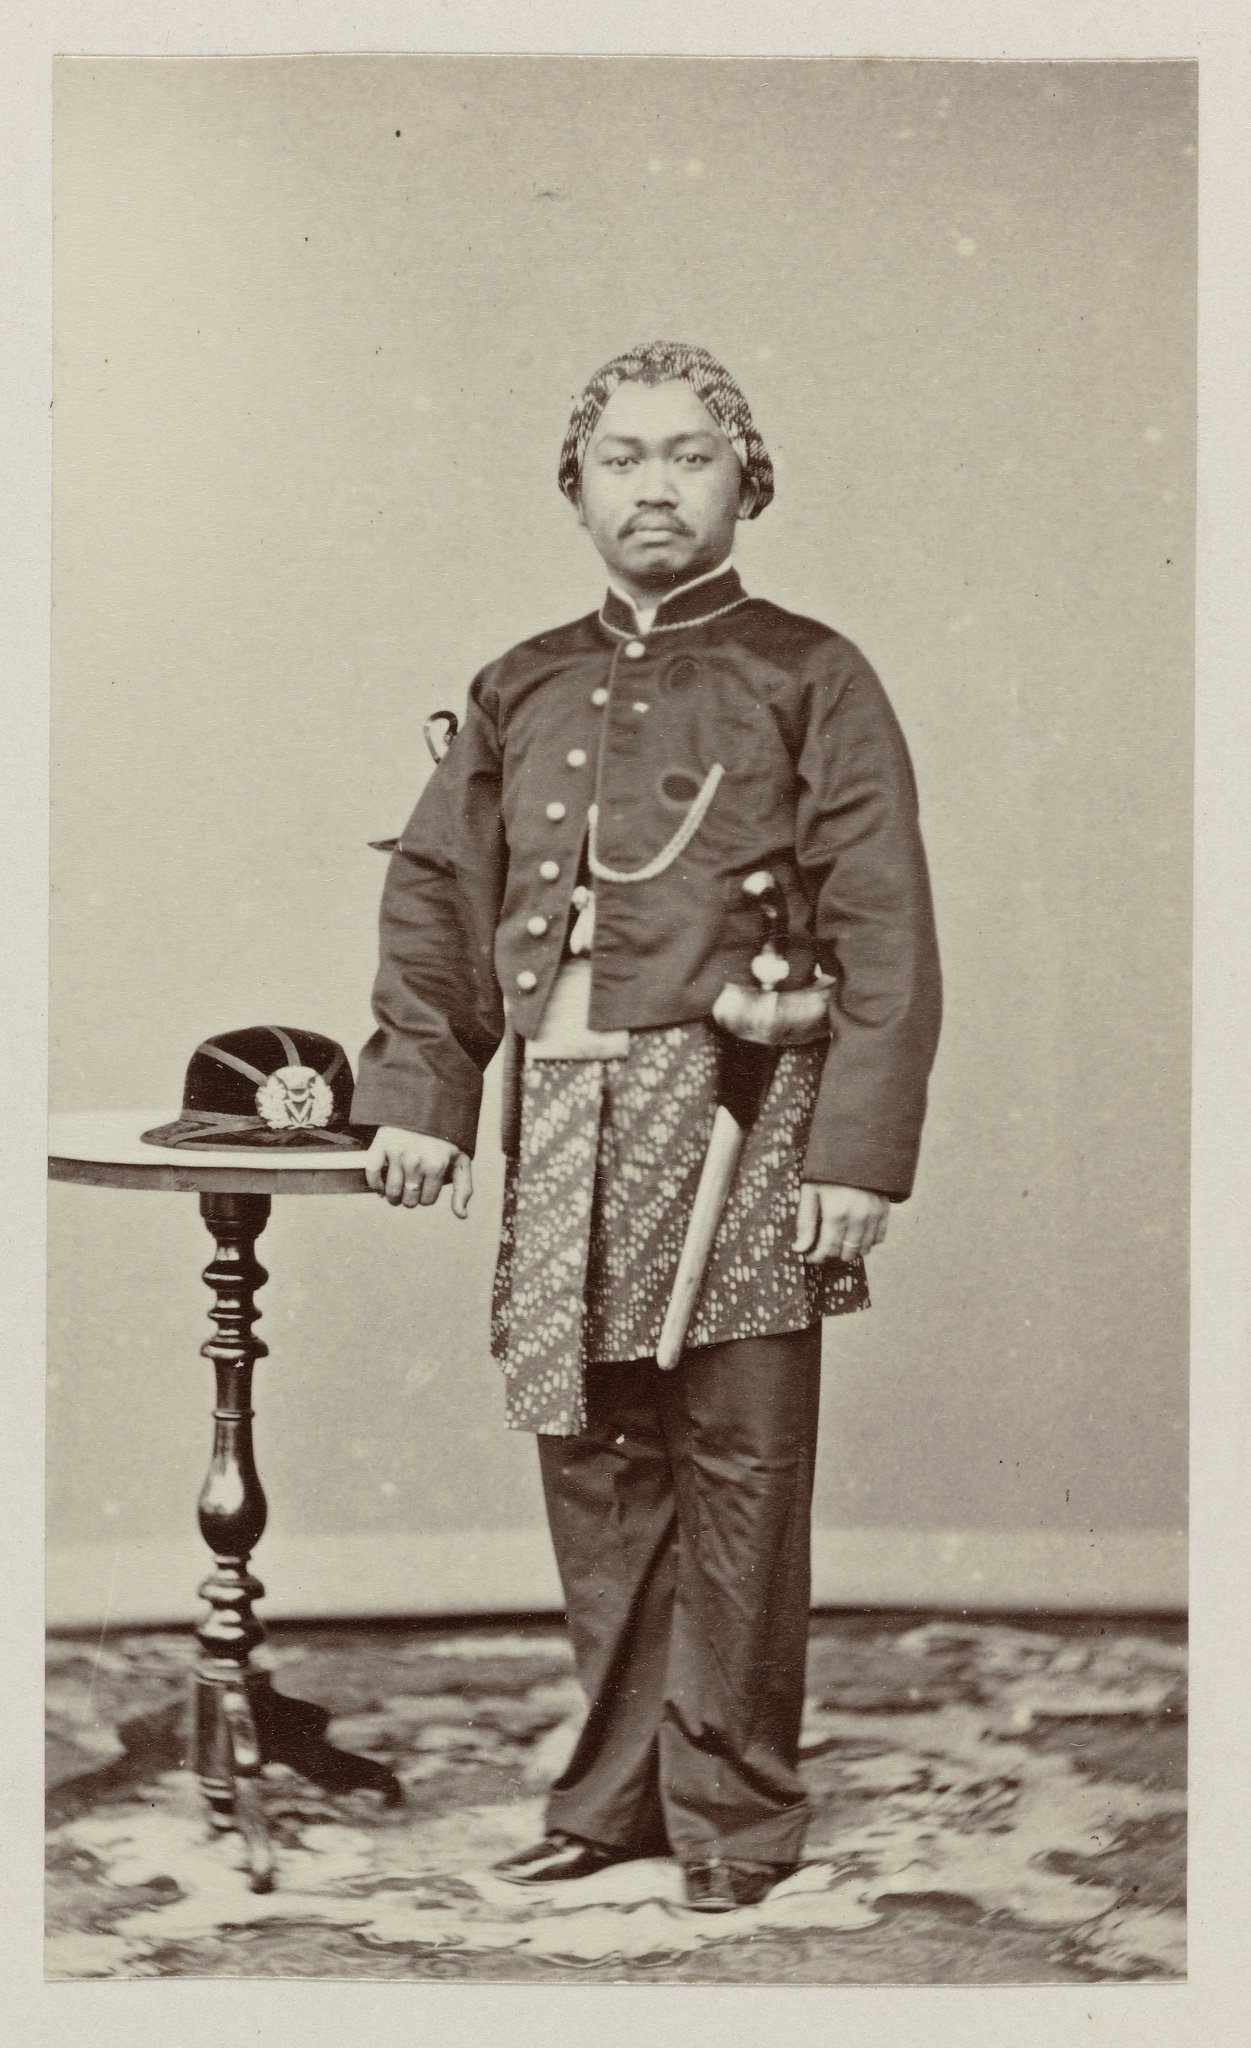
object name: photograph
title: Portret van de regent van Blora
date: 1860-1890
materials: photographic support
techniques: albumen print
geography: batavia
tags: historical persons, java, batavia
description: Studioportret van Raden Tumenggung Cakranagara II, regent van Blora, staande bij een tafeltje. Ingeplakte foto in het fotoalbum getiteld: Gezichten van Java.